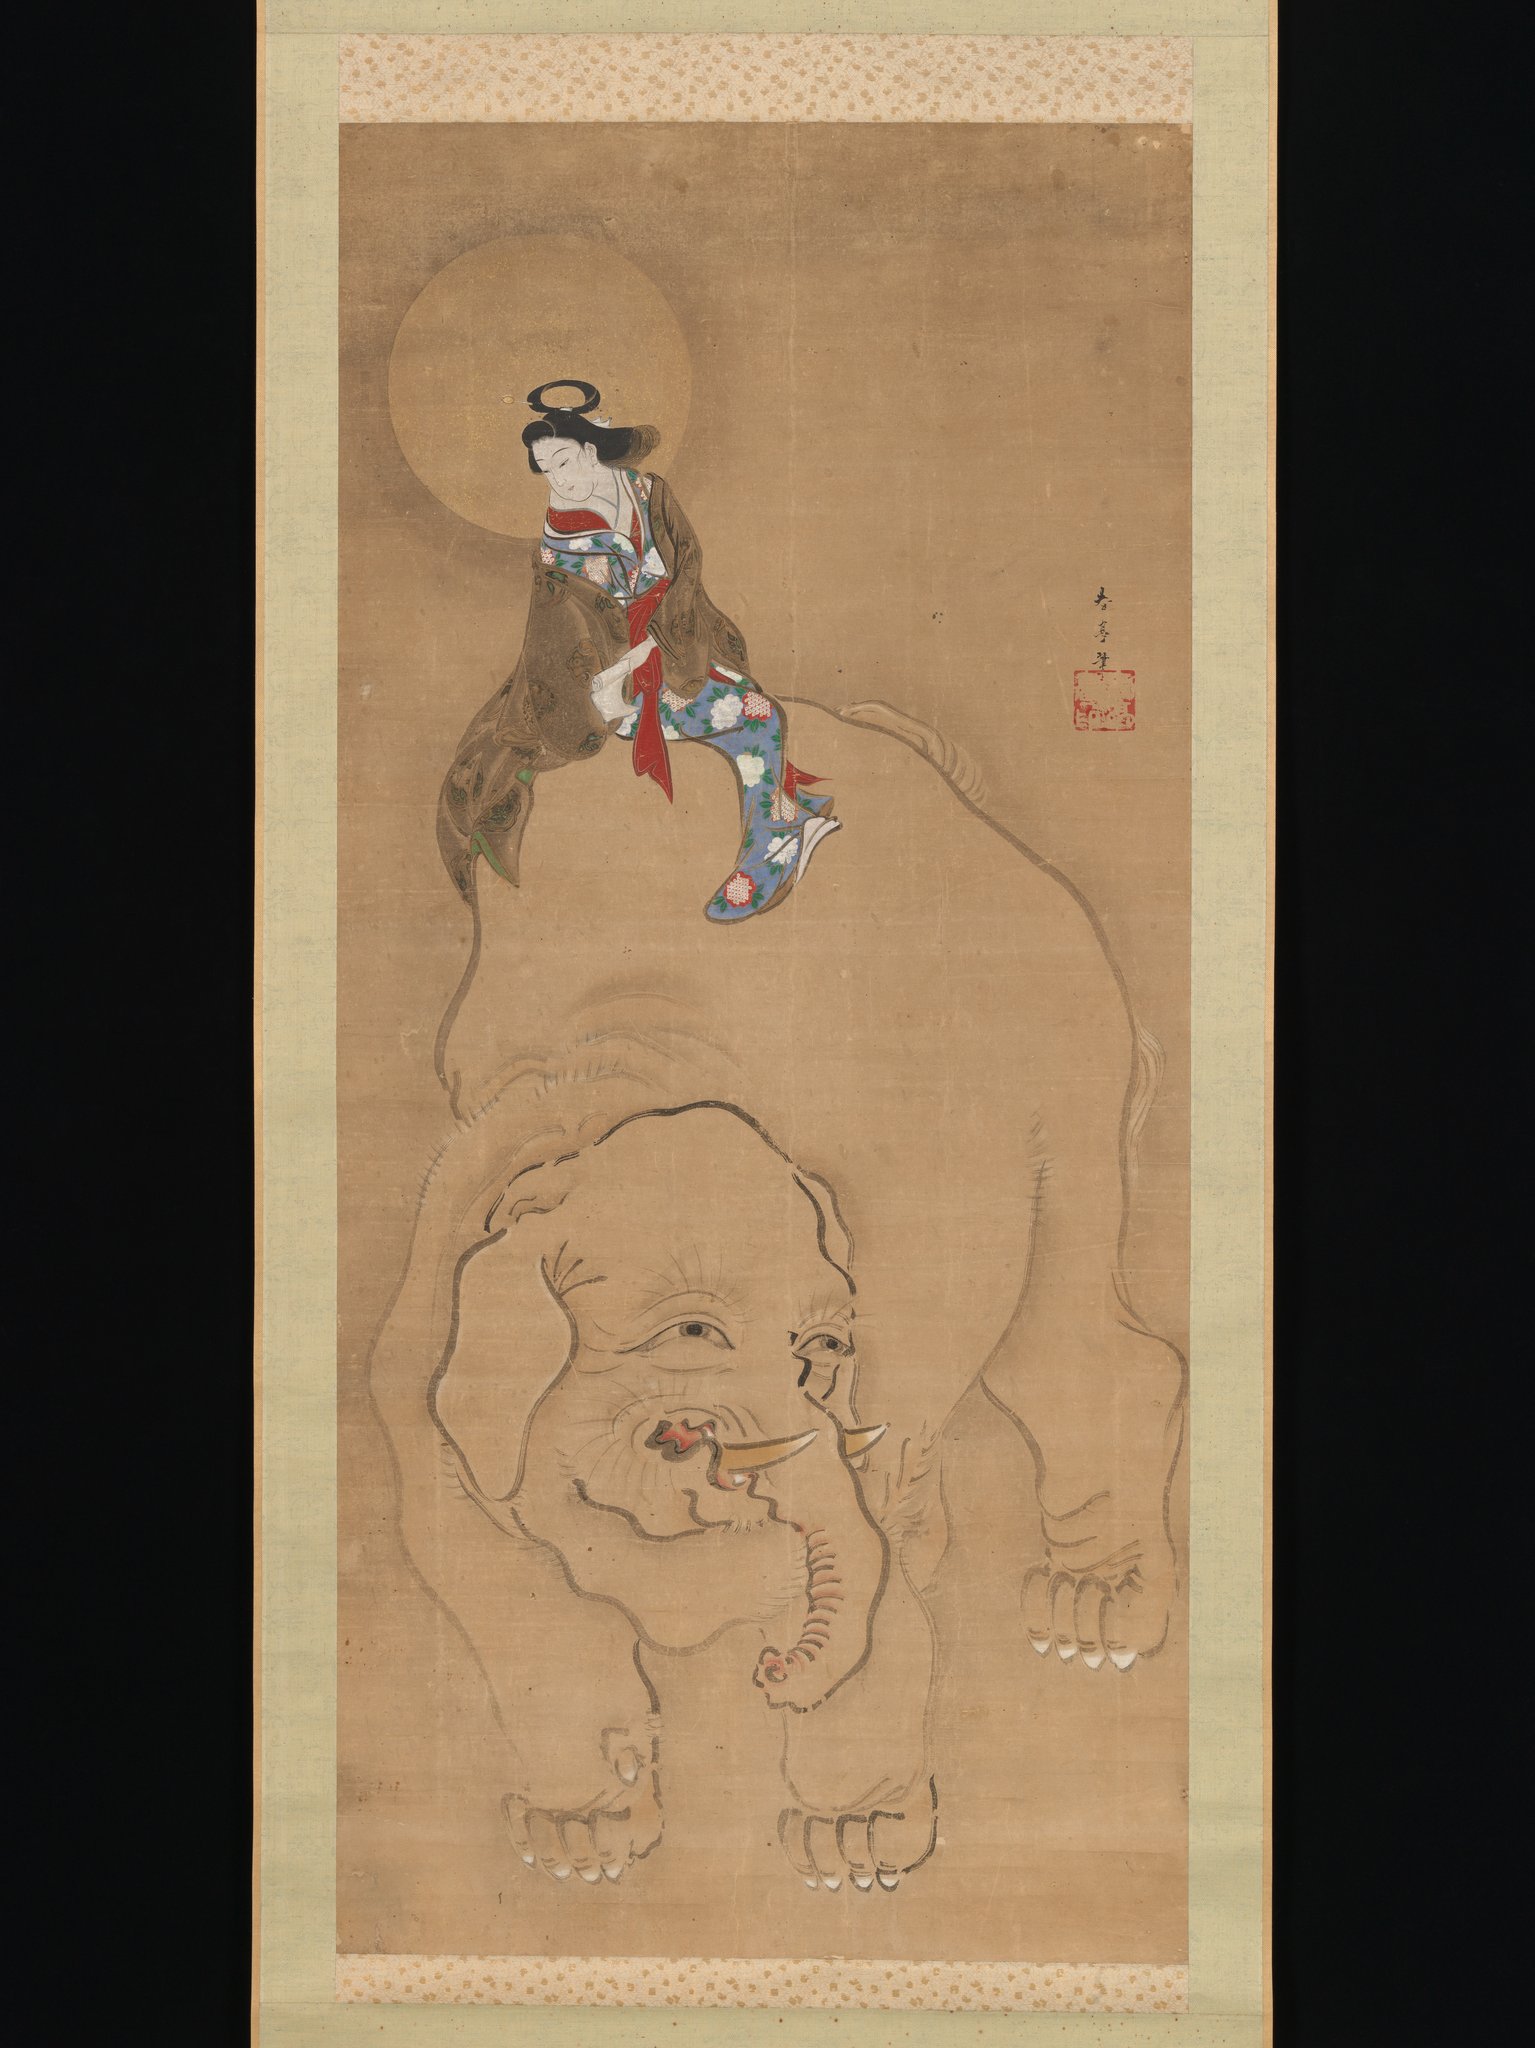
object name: hanging scroll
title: Eguchi no Kimi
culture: japanese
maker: katsukawa shuntei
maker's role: artist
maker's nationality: japanese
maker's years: 1770-1820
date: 1767-1833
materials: gold, ink, paper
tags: women,elephants